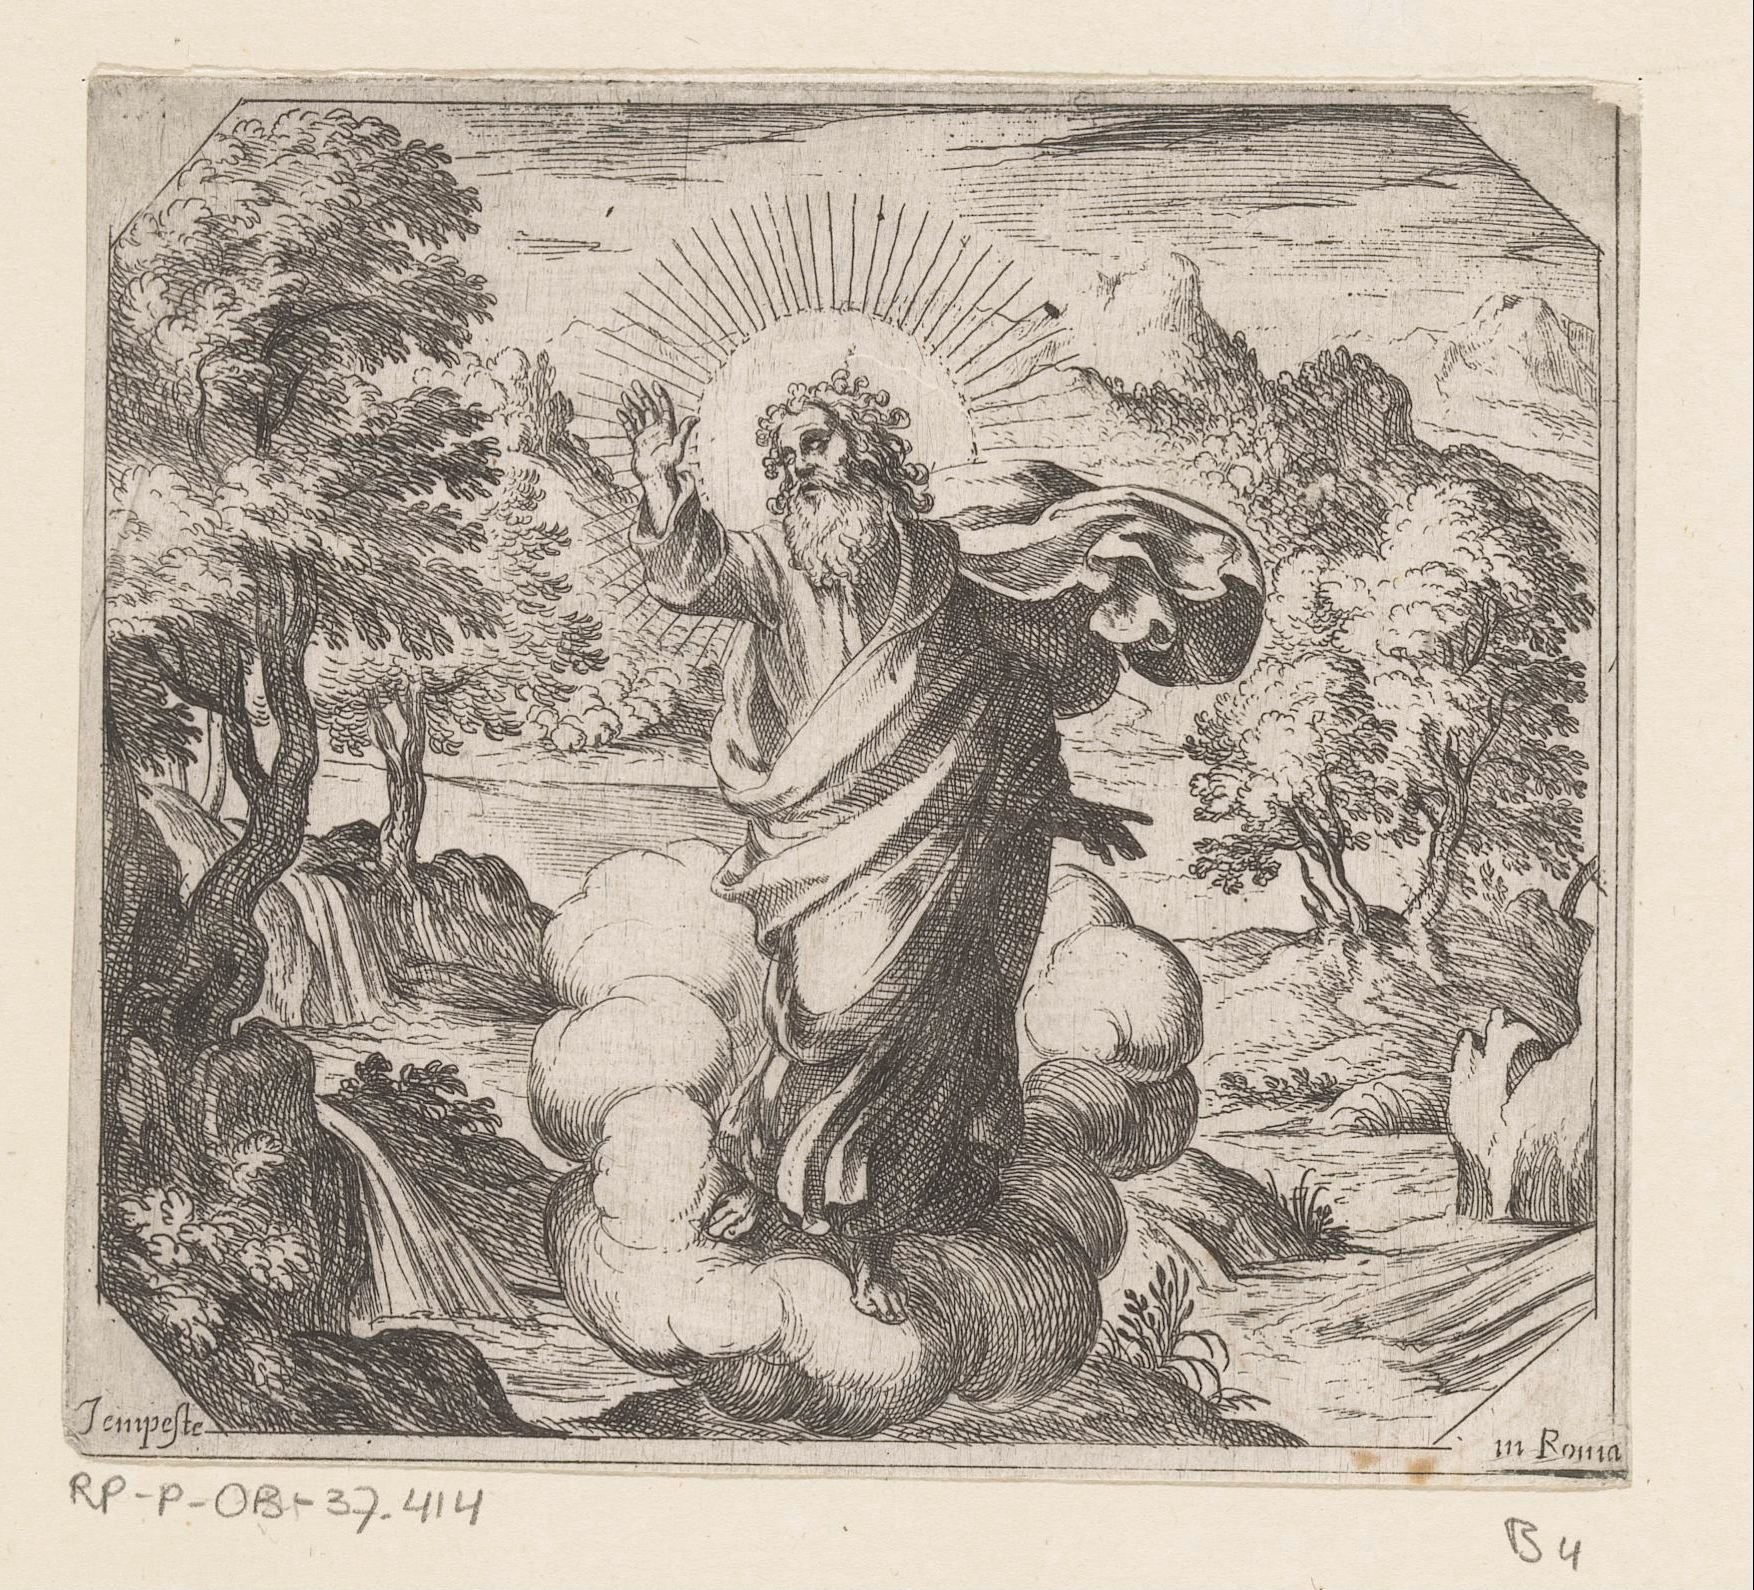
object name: print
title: God schept planten en bomen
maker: antonio tempesta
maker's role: draughtsman, painter, print maker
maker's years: 1555-1630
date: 1565-1630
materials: paper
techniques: etching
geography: rome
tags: gathering of the waters below the firmament; dry land appears and produces all kinds of plants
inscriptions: collector's mark: Lugt 240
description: Deze prent maakt deel uit van een serie van twaalf prenten van de schepping. De prenten zijn deels naar ontwerpen van Rafaël voor de Loggia van Rafaël in het Vaticaan, en deels naar prenten door Nicolaes de Bruyn naar ontwerpen van Maerten de Vos (zie: Holl. Dutch. vol. 45 nr. 1-10).